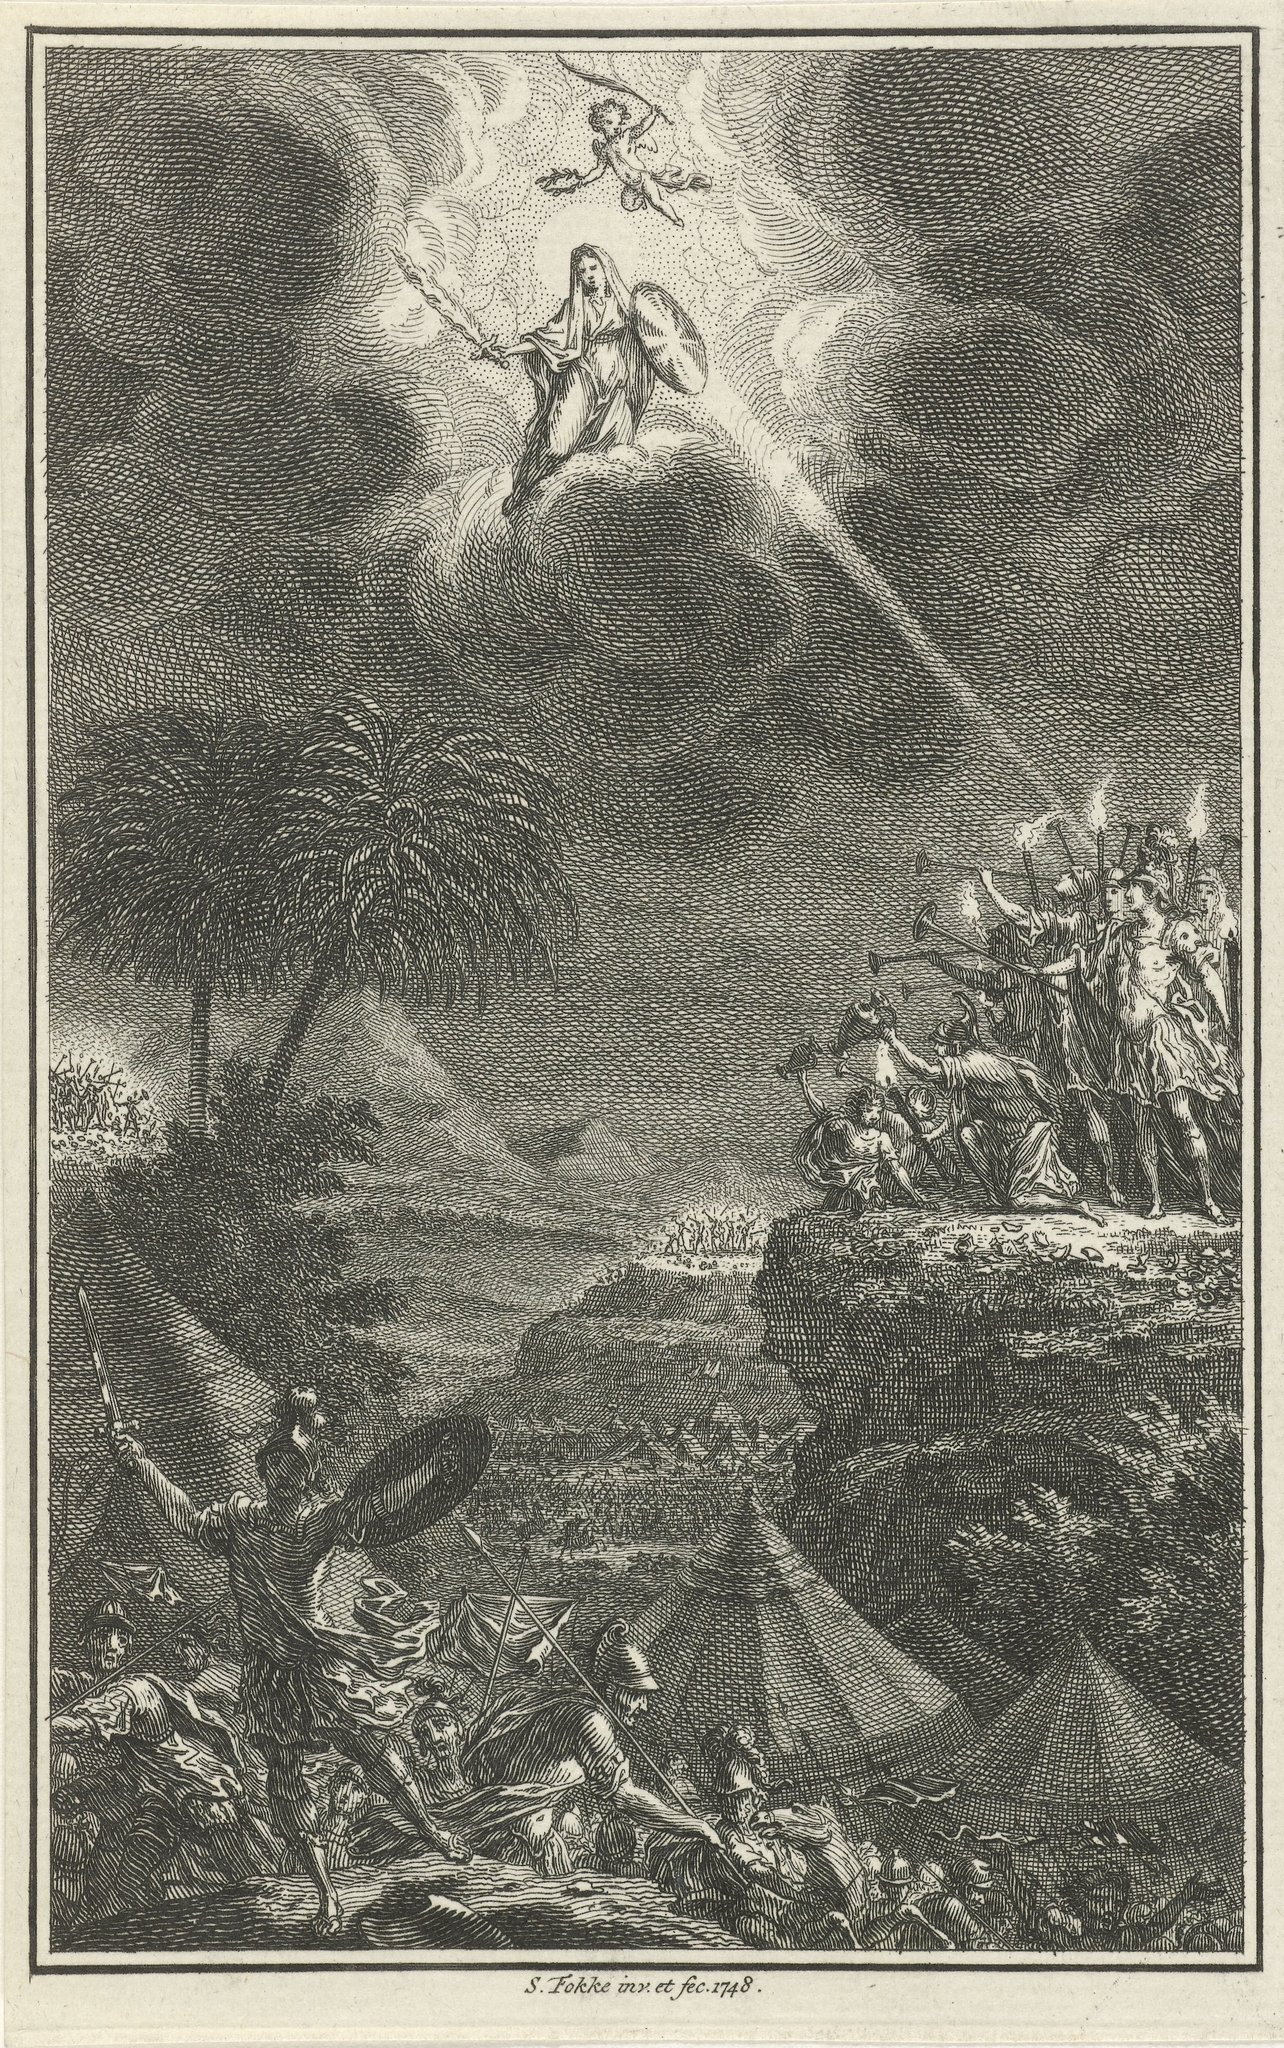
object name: print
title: Veldslag in een vallei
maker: simon fokke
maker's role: draughtsman, print maker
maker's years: 1712-1784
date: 1748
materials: paper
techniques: etching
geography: amsterdam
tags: battle, fighting in general, light shining out of the heavens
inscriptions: collector's mark: Lugt 240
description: Strijdende militairen te paard en te voet bij een tentenkamp. Rechts wordt de legeraanvoerder met helm en bazuin in de hand beschenen met een bundel licht, afkomstig uit de hemel. In de wolken weerkaatst een gesluierde vrouw met brandend zwaard het licht met haar schild naar de aarde. Boven haar vliegt een putto met palmtalk en lauwerkrans.